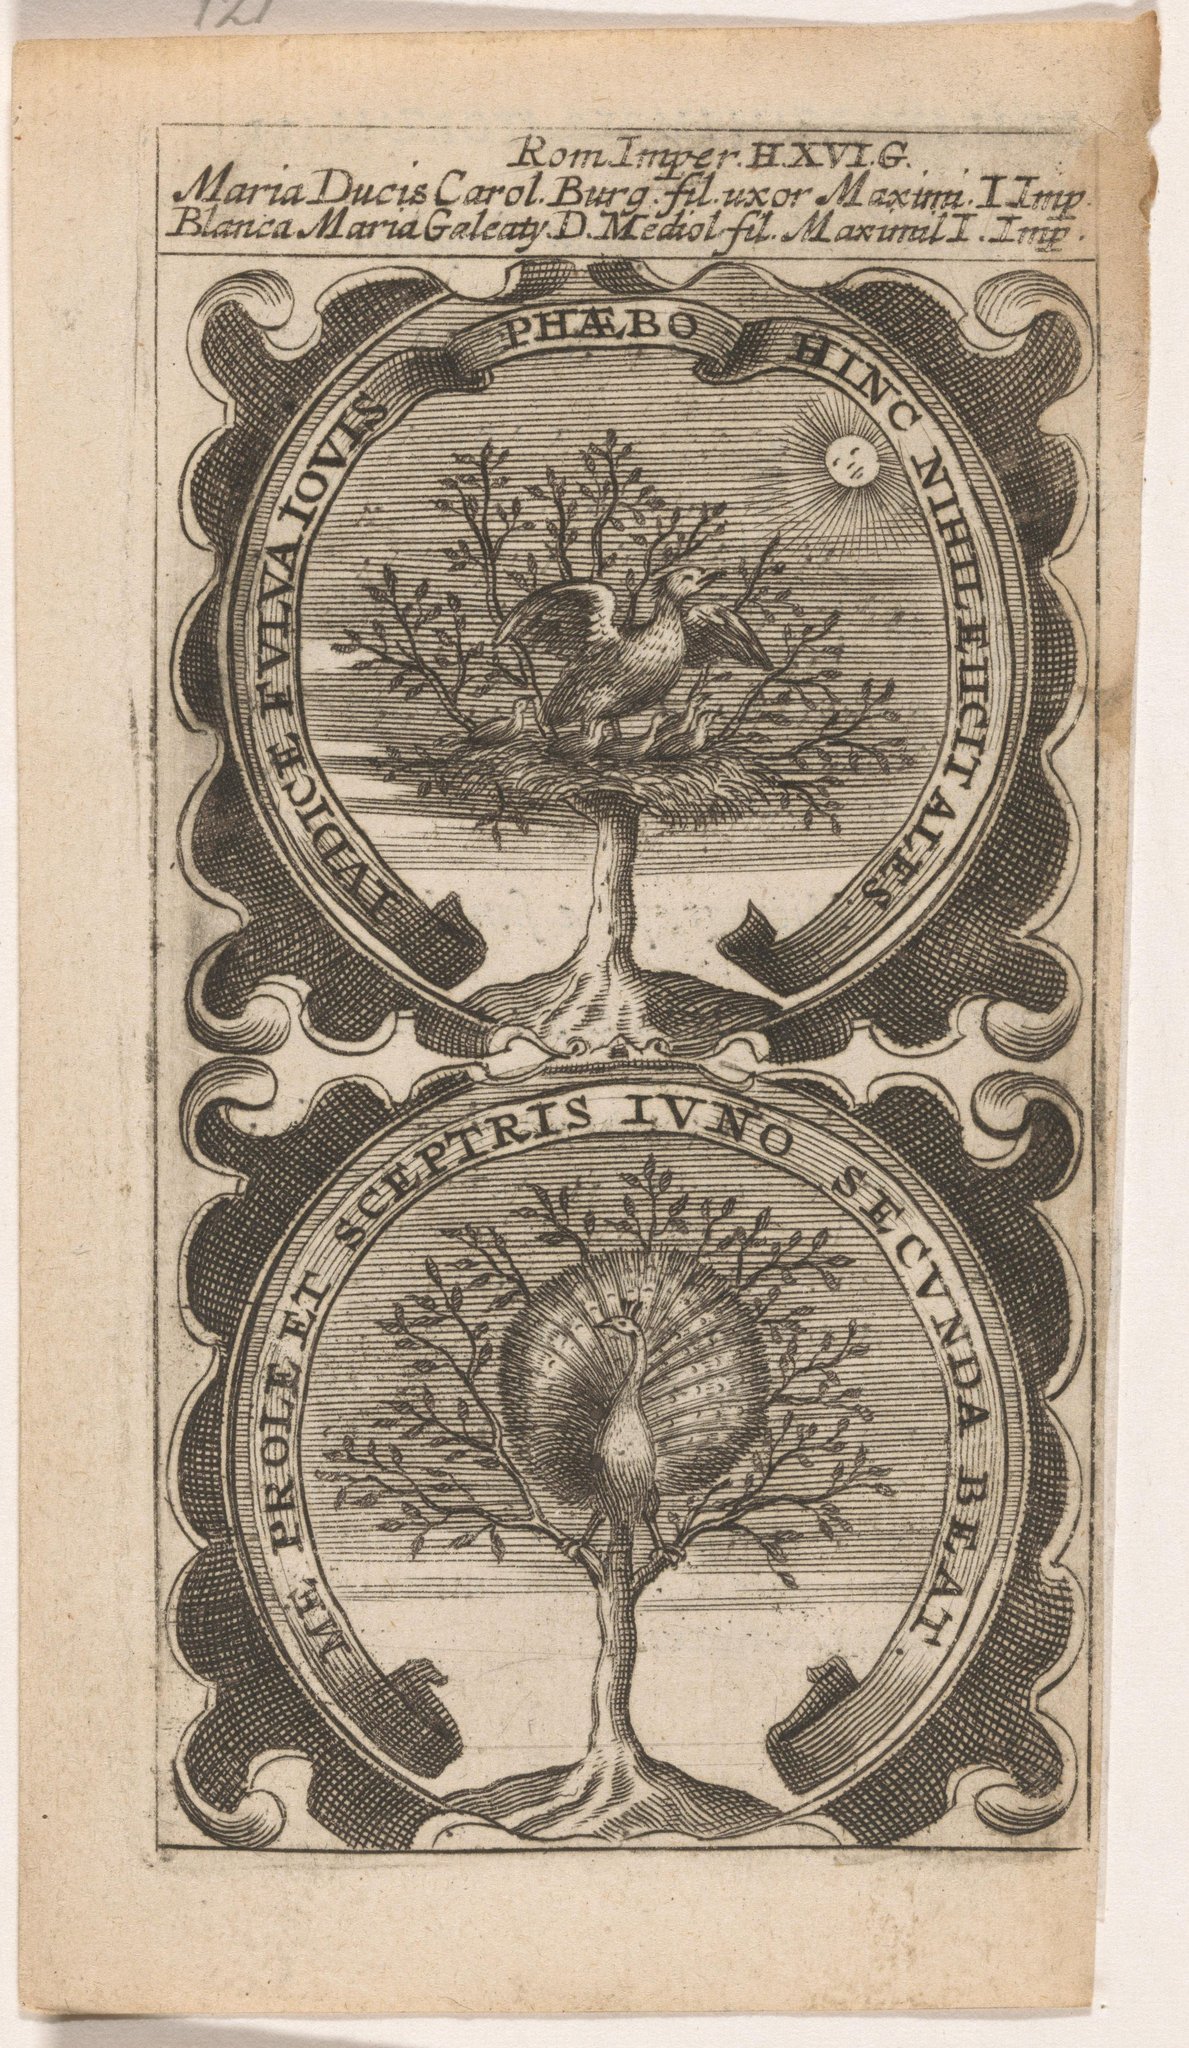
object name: book illustration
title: Symbola Divina et Humana Pontificum Imperatorum Regum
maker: Anonymous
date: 1666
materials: paper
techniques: engraving, letterpress printing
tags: brussels, bruges, maria (hertogin van bourgondië), trees, ornamental birds: peacock, water-birds: pelican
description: Pagina uit Jacob Typotius, Symbola Divina & Humana Pontificum Imperatorum Regum. Arnhem, J.F. Hagen, 1666 of uit de titeluitgave van 1669 of 1679. Het werk van Typotius werd voor het eerst uitgegeven in 1601 met prenten van Aegidius Sadeler.